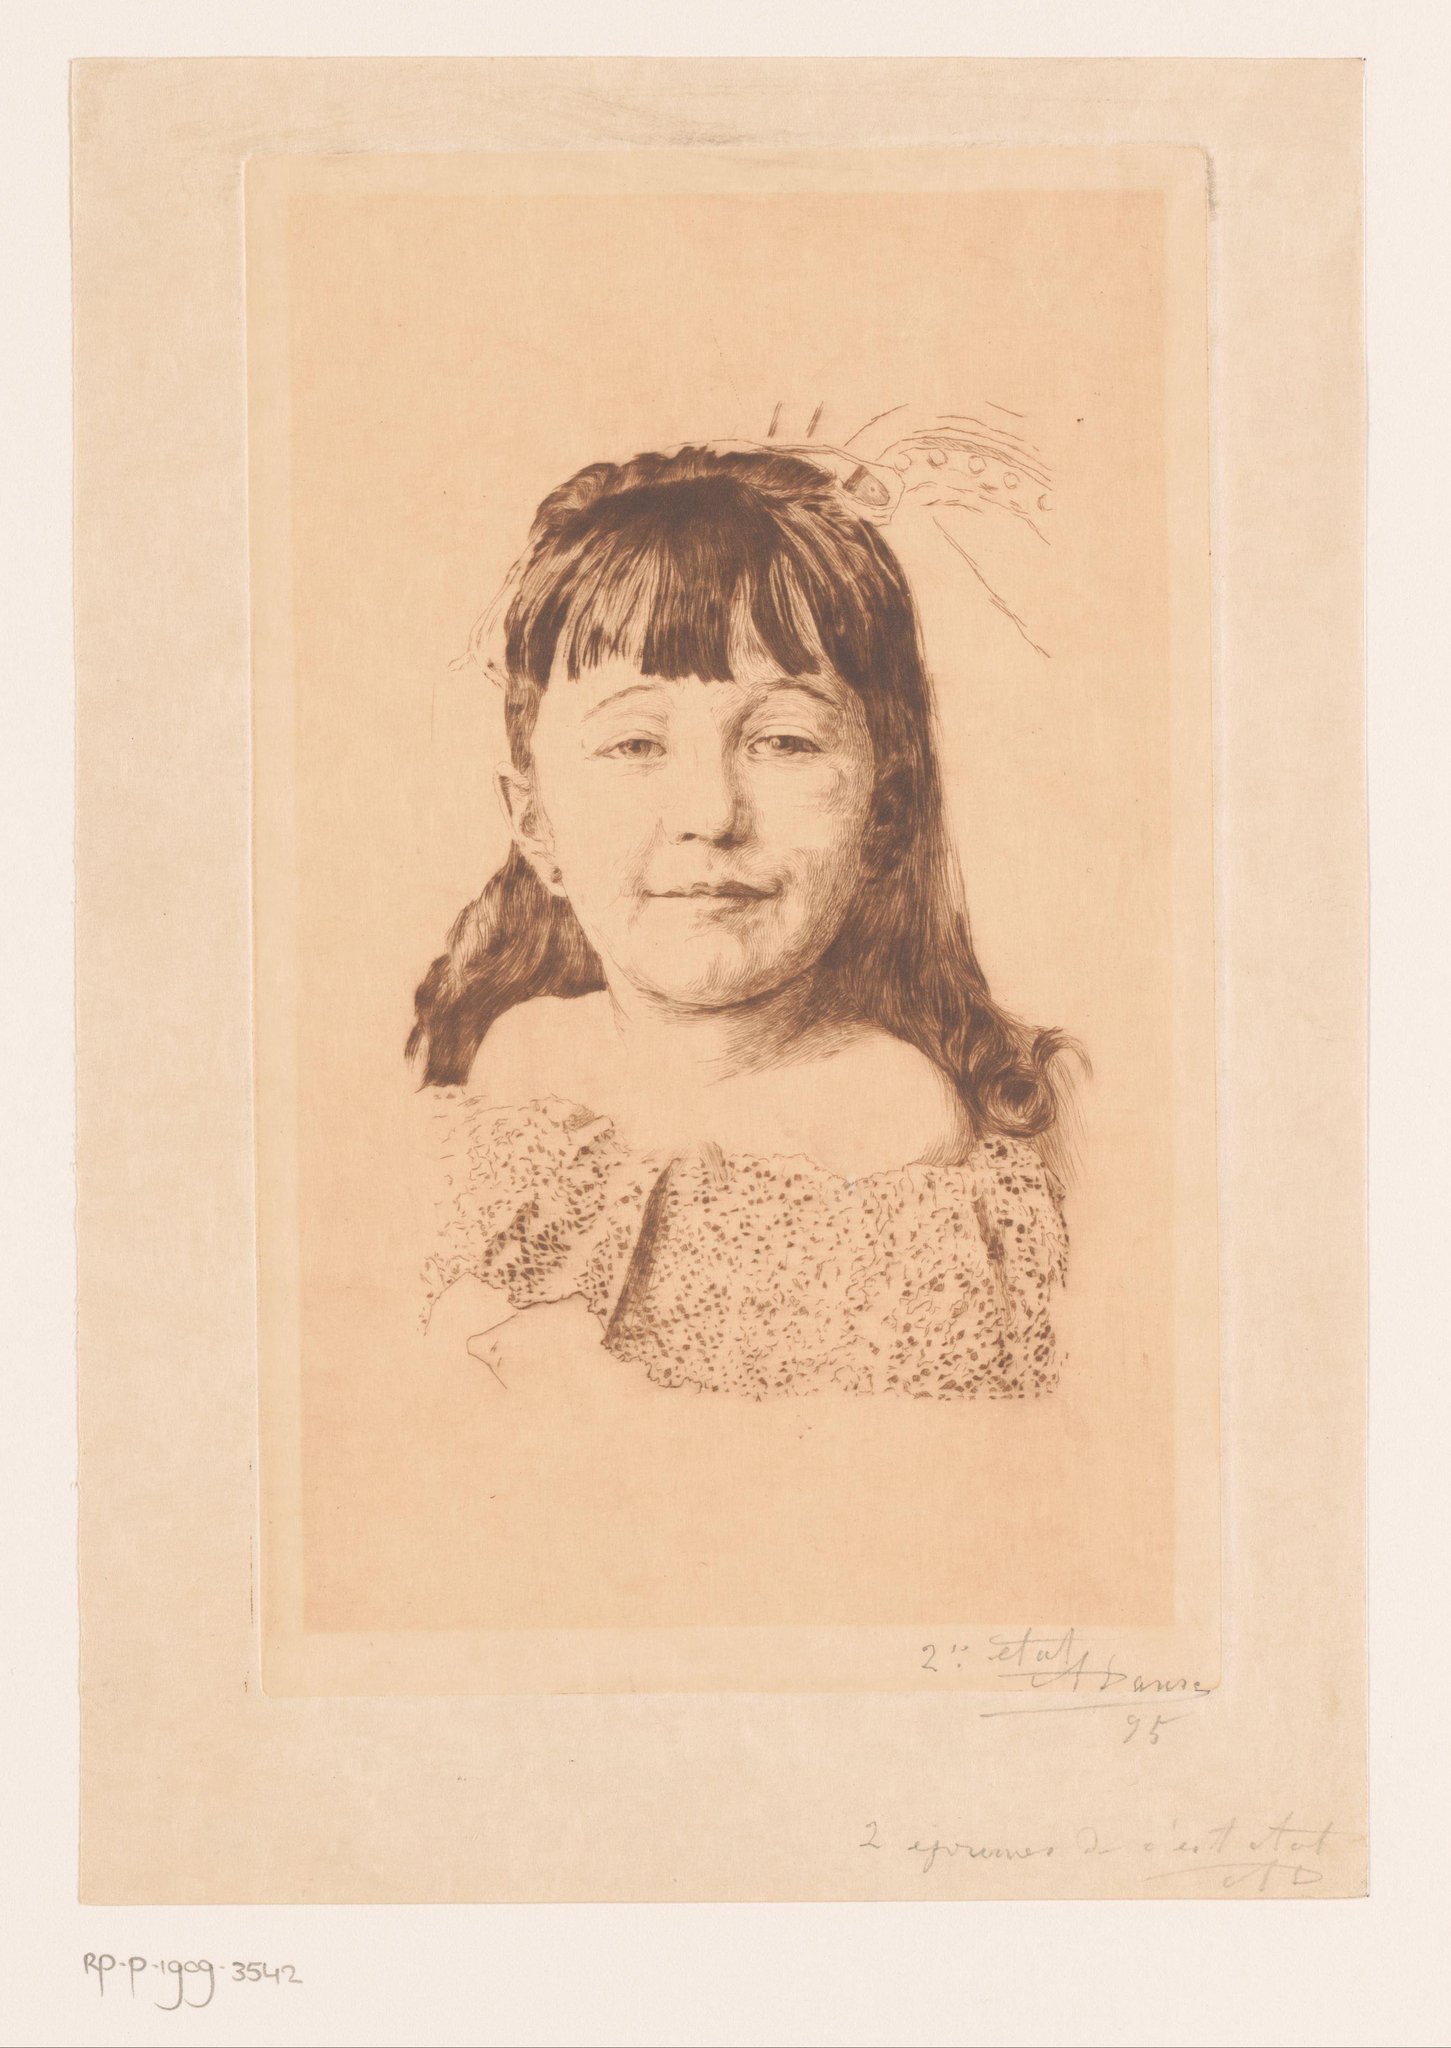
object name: print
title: Portret van een onbekend meisje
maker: auguste danse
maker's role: print maker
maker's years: 1829-1929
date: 1895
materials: paper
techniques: drypoint, etching, intaglio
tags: adolescent, young woman, maiden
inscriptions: annotation: ‘2me etat; 2 epreuves de c'est etat’, collector's mark: Lugt 2228